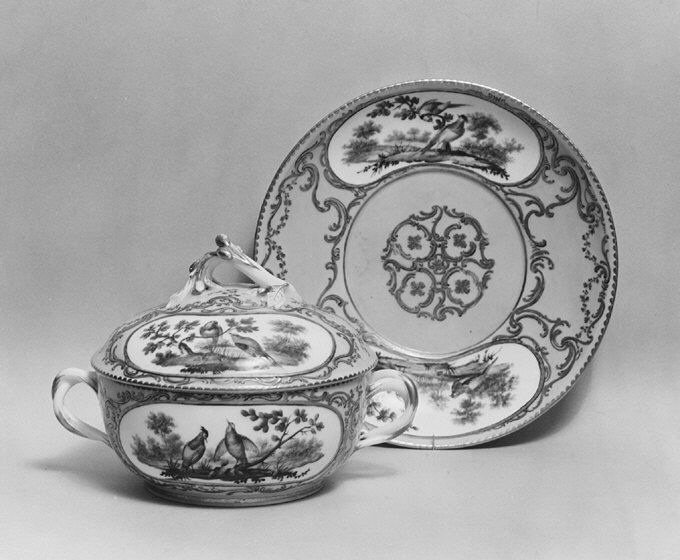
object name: bowl with cover and tray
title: Bowl with cover (écuelle) and tray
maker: sèvres manufactory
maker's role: manufactory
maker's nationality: french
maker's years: 1740-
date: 1760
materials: soft paste porcelain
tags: birds,flowers